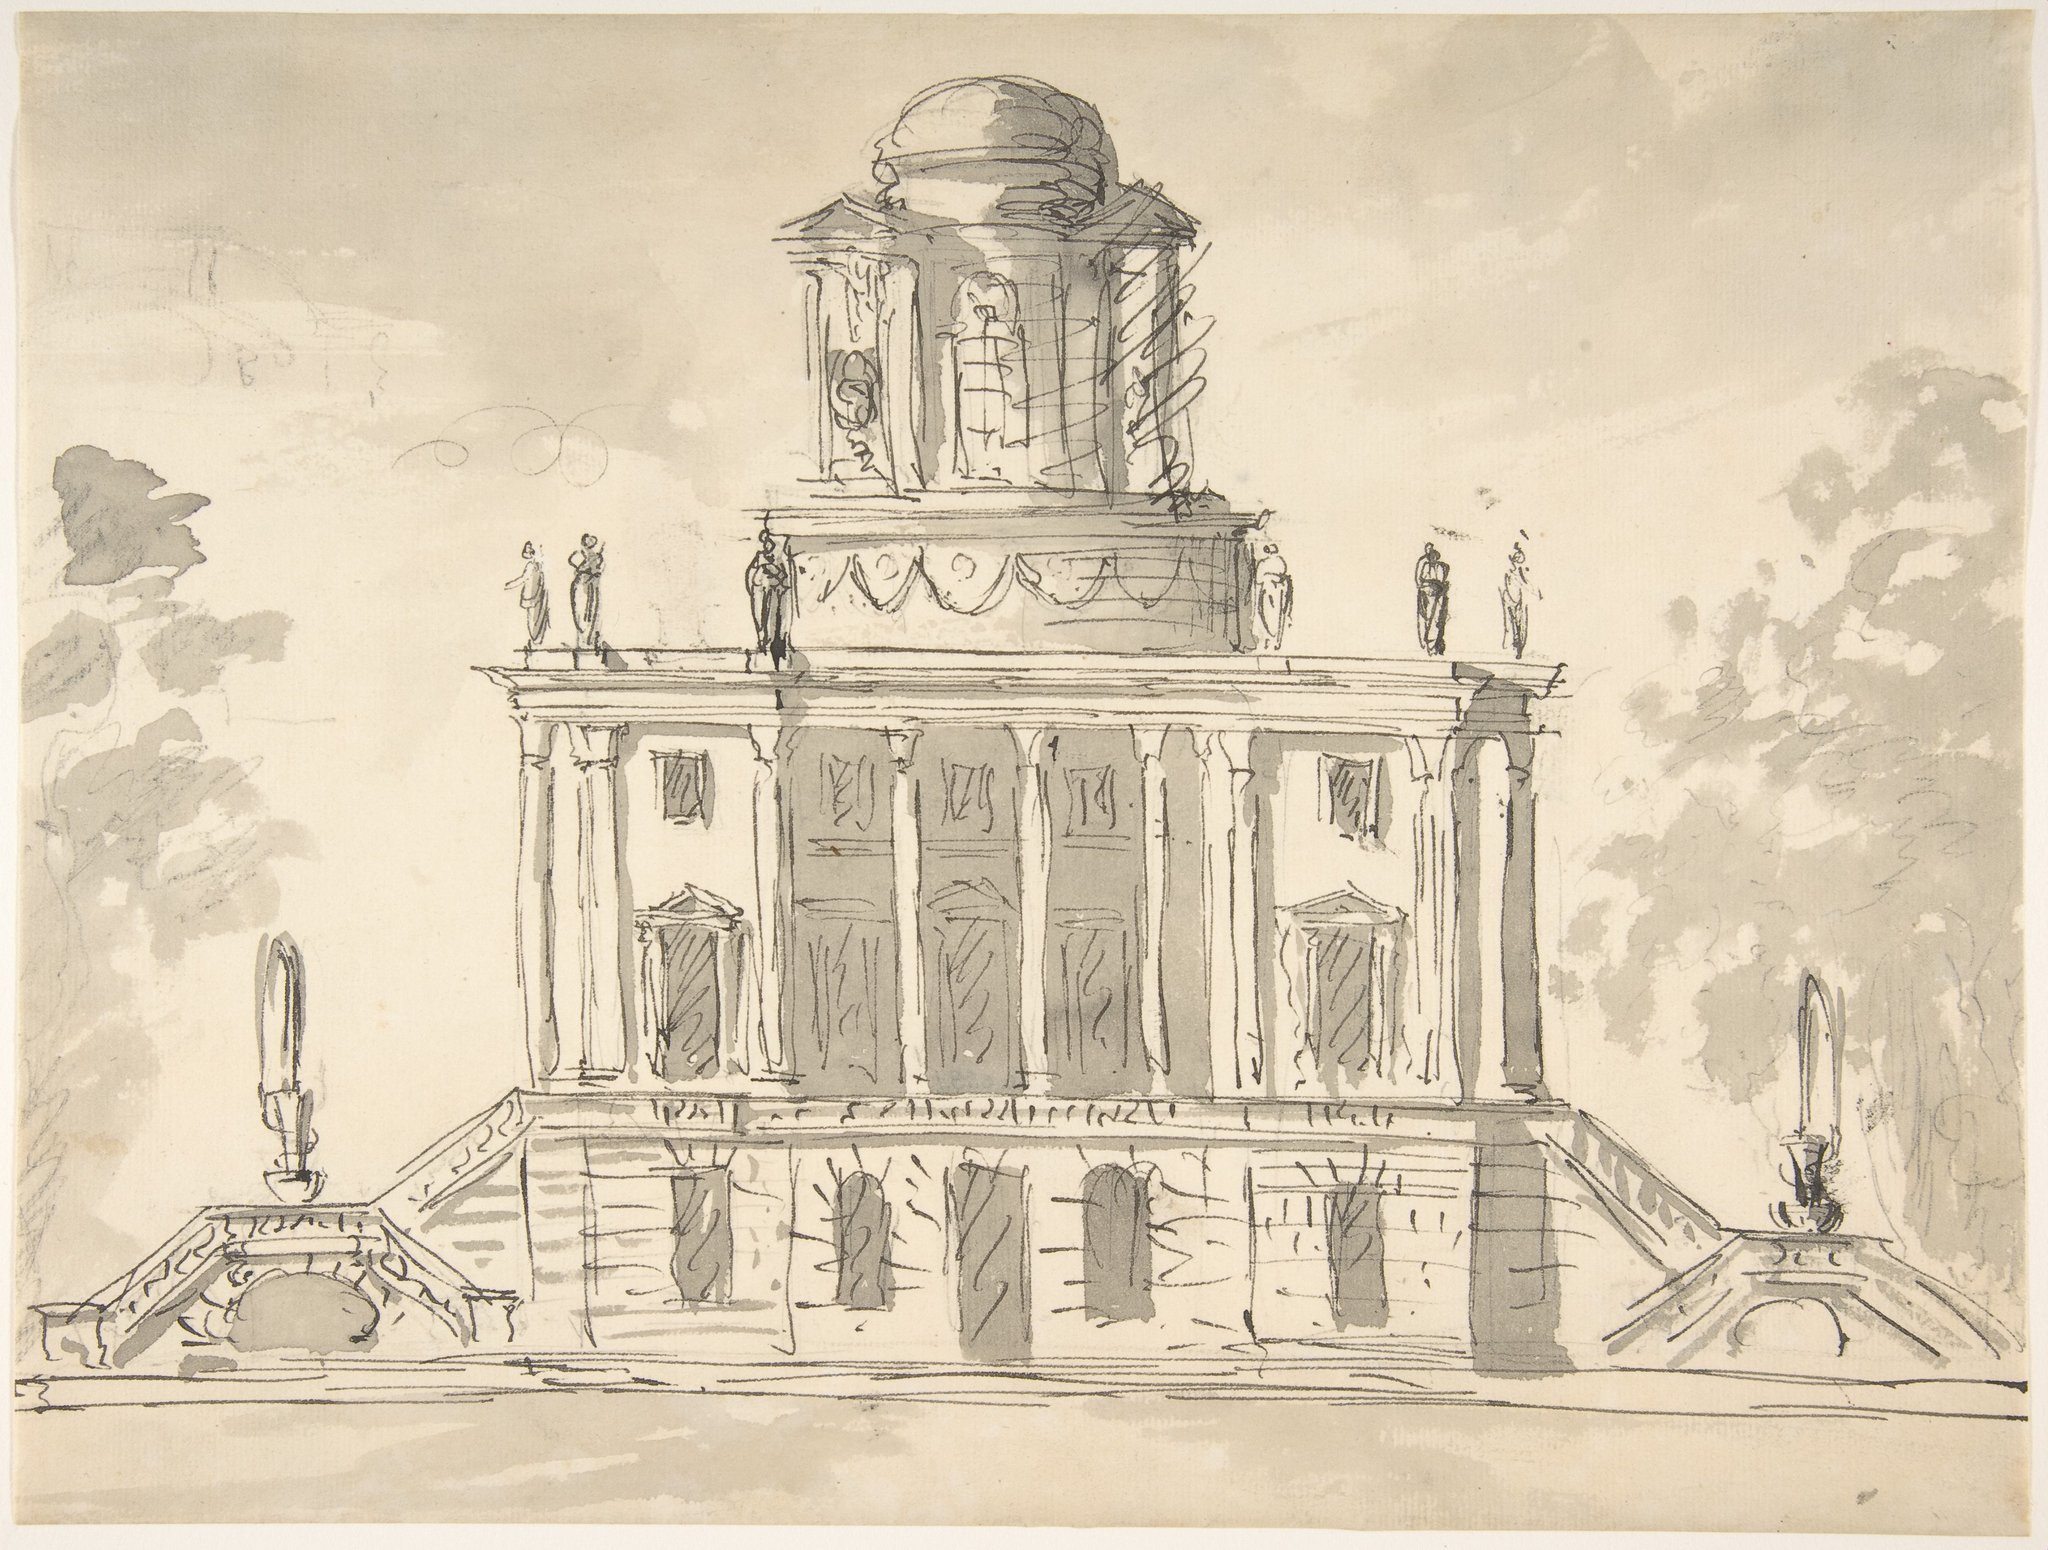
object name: drawing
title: Design for a Mausoleum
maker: sir william chambers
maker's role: artist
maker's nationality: british, born sweden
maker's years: 1723-1796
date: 1740-1800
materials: graphite, ink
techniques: brush, pen, wash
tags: human figures,buildings